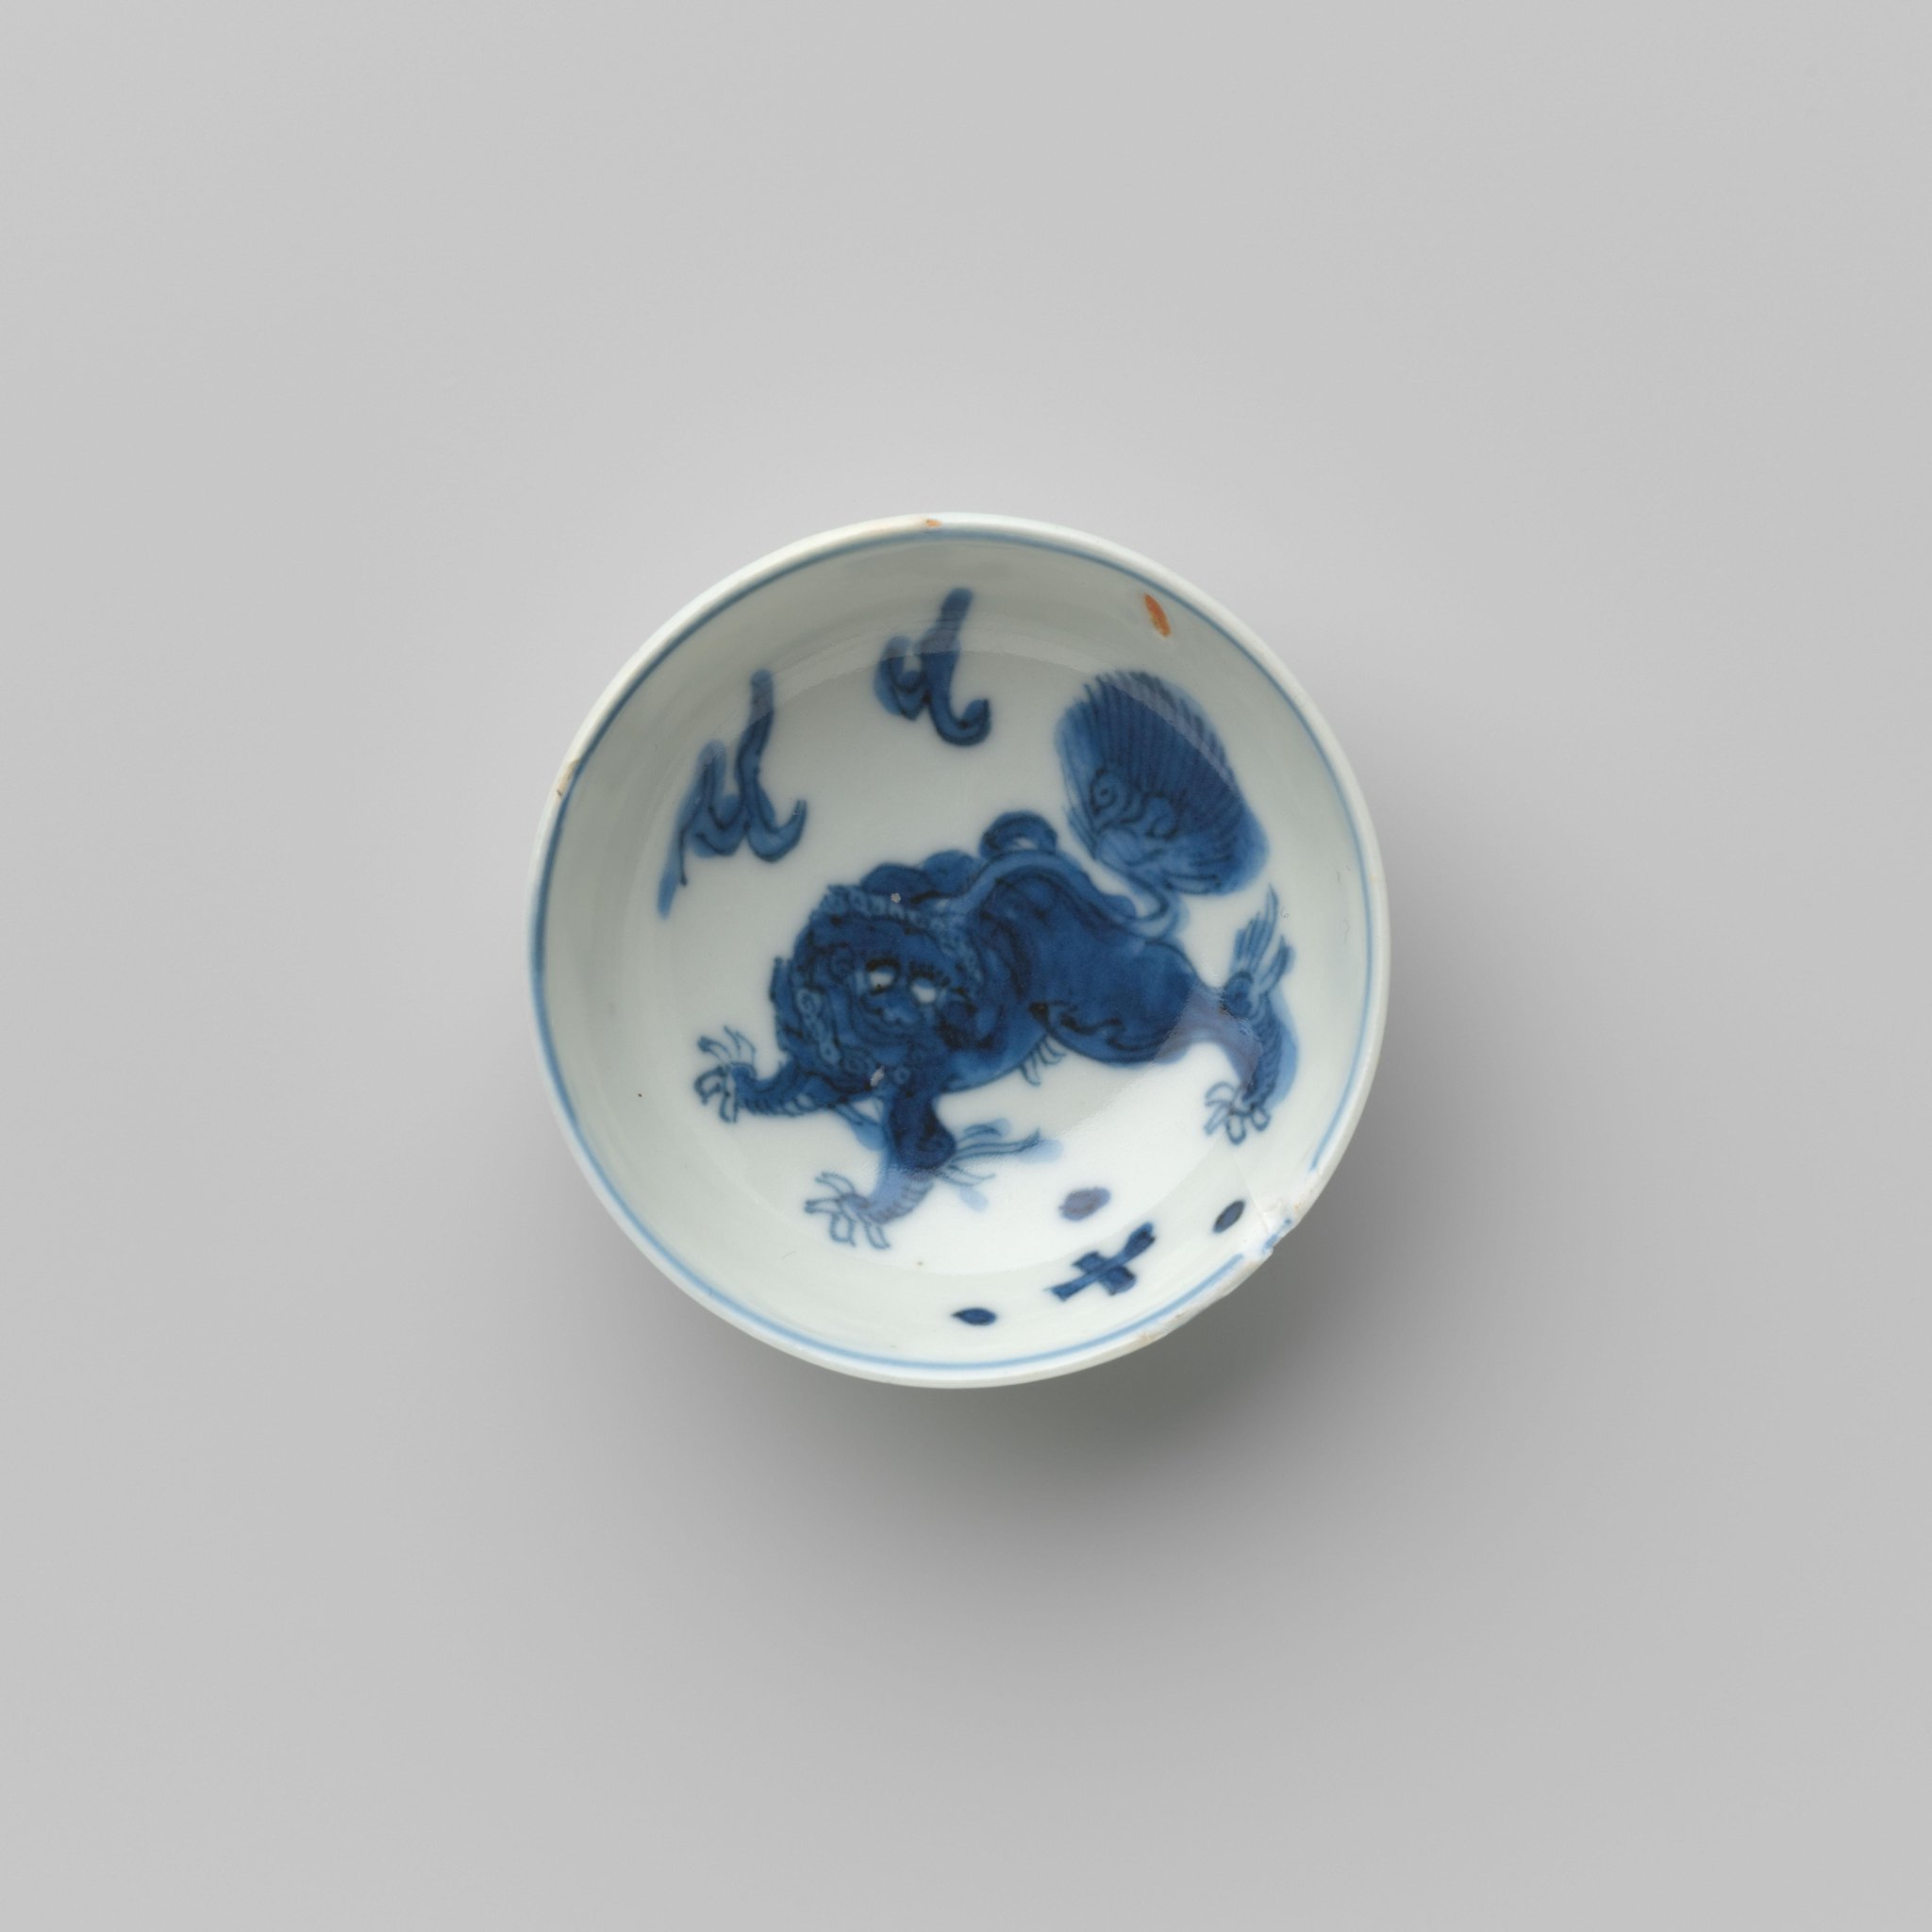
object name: miniature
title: Miniature saucer-dish with a shishi and branches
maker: Anonymous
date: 1675-1699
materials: cobalt, glaze, paint, porcelain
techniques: firing, turning, vitrification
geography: china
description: Miniatuur schaal van porselein, beschilderd in onderglazuur blauw. Op het plat een shishi, waaronder een kruis. De buitenwand met takken. Blauw-wit.